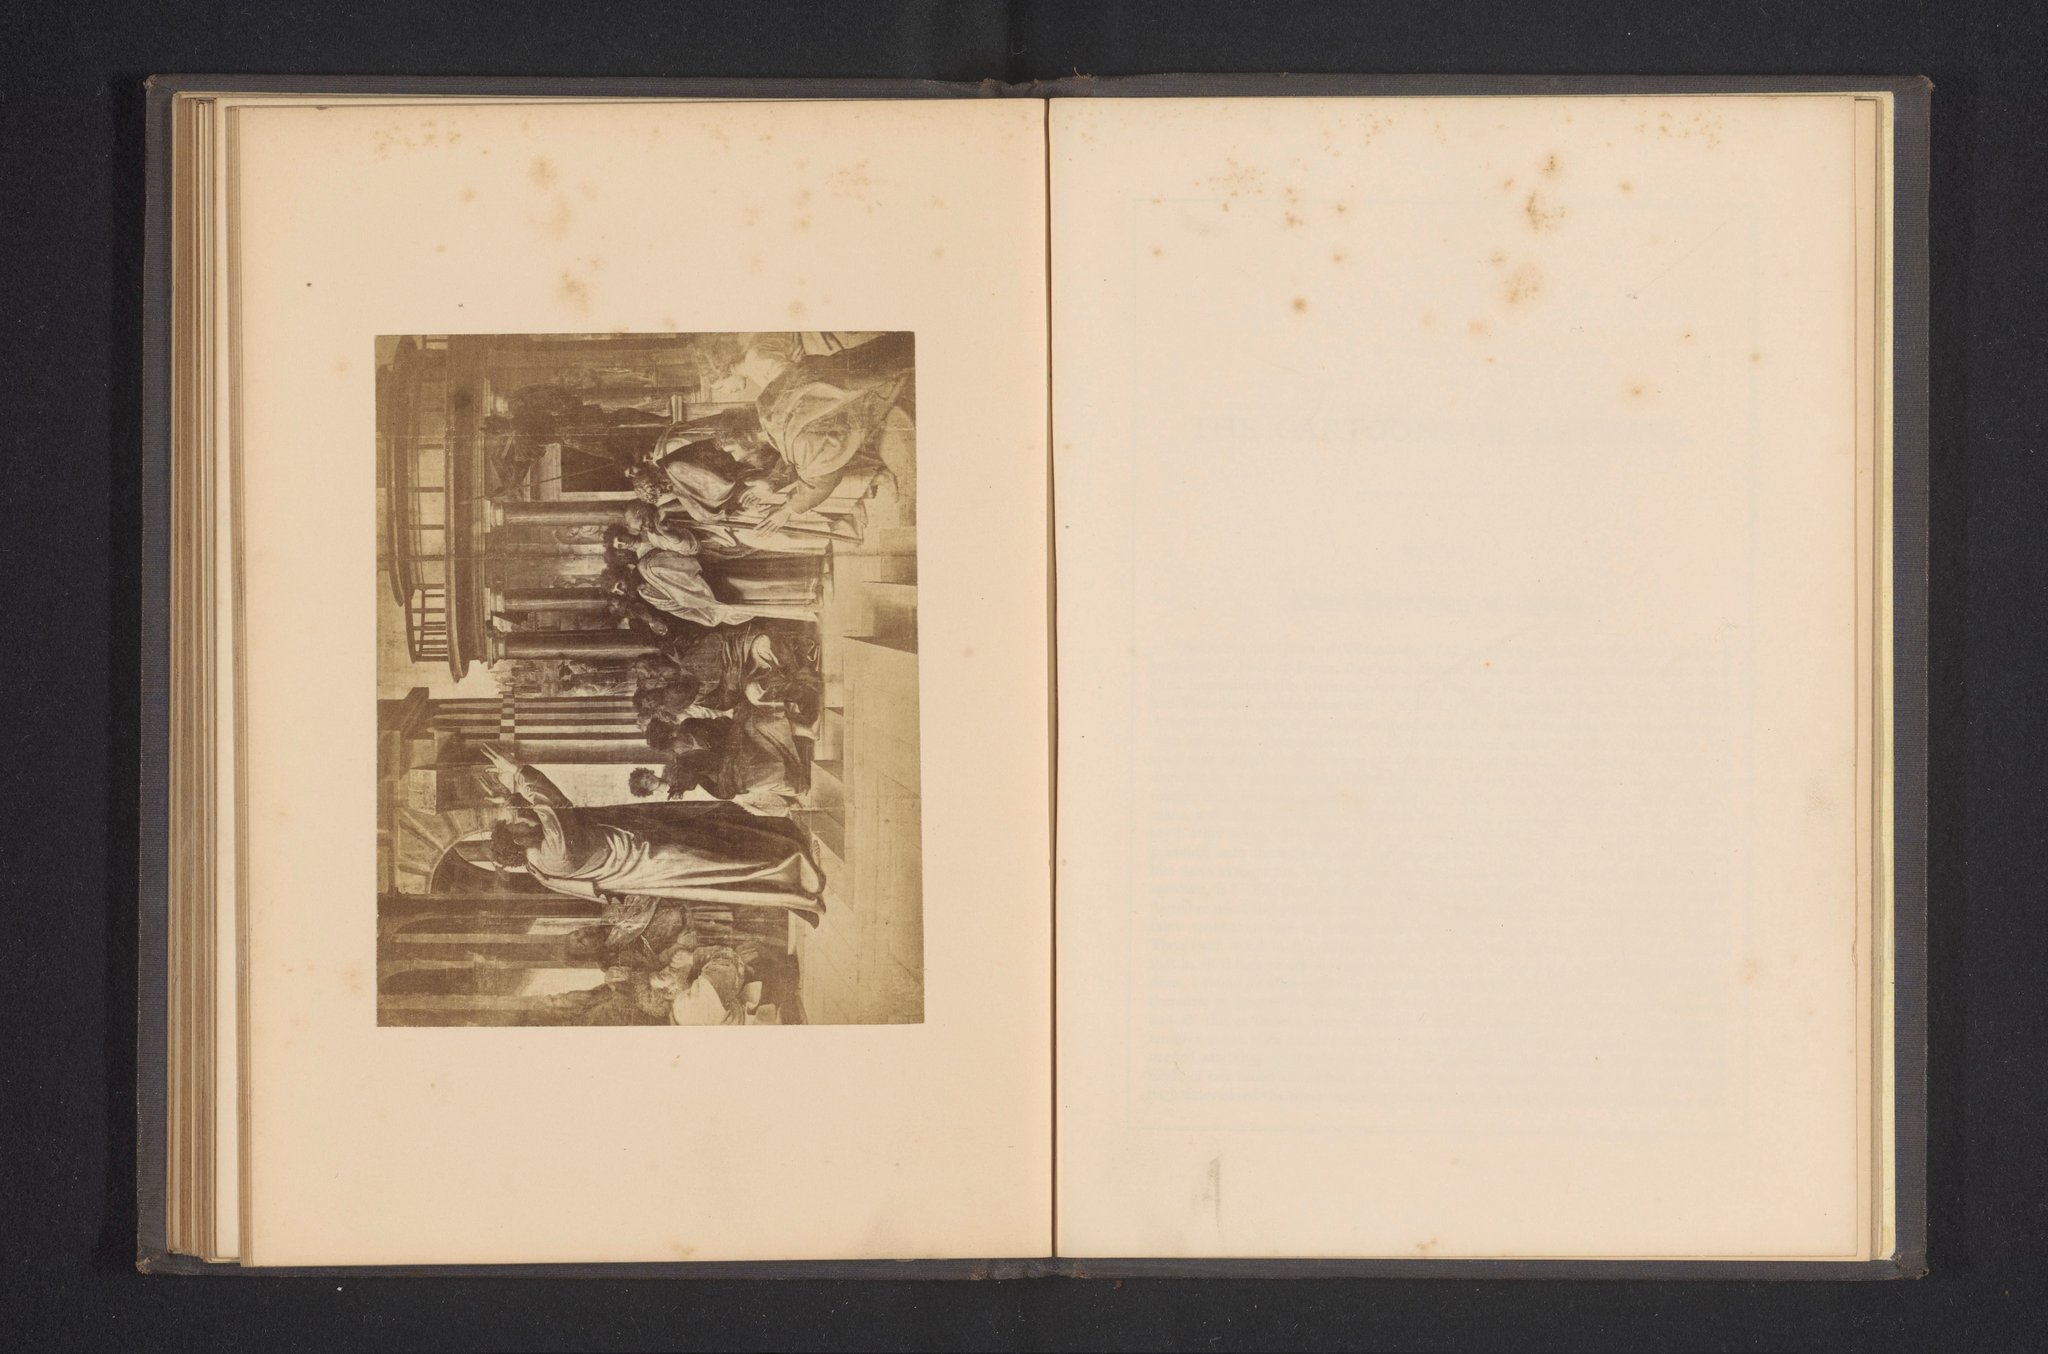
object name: page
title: Fotoreproductie van een kartonschildering, voorstellende de prediking van Paulus te Athene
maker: Anonymous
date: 1850-1860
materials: photographic support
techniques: albumen print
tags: paul in athens: on the areopagus he discusses with philosophers (in front of the temple of mars)